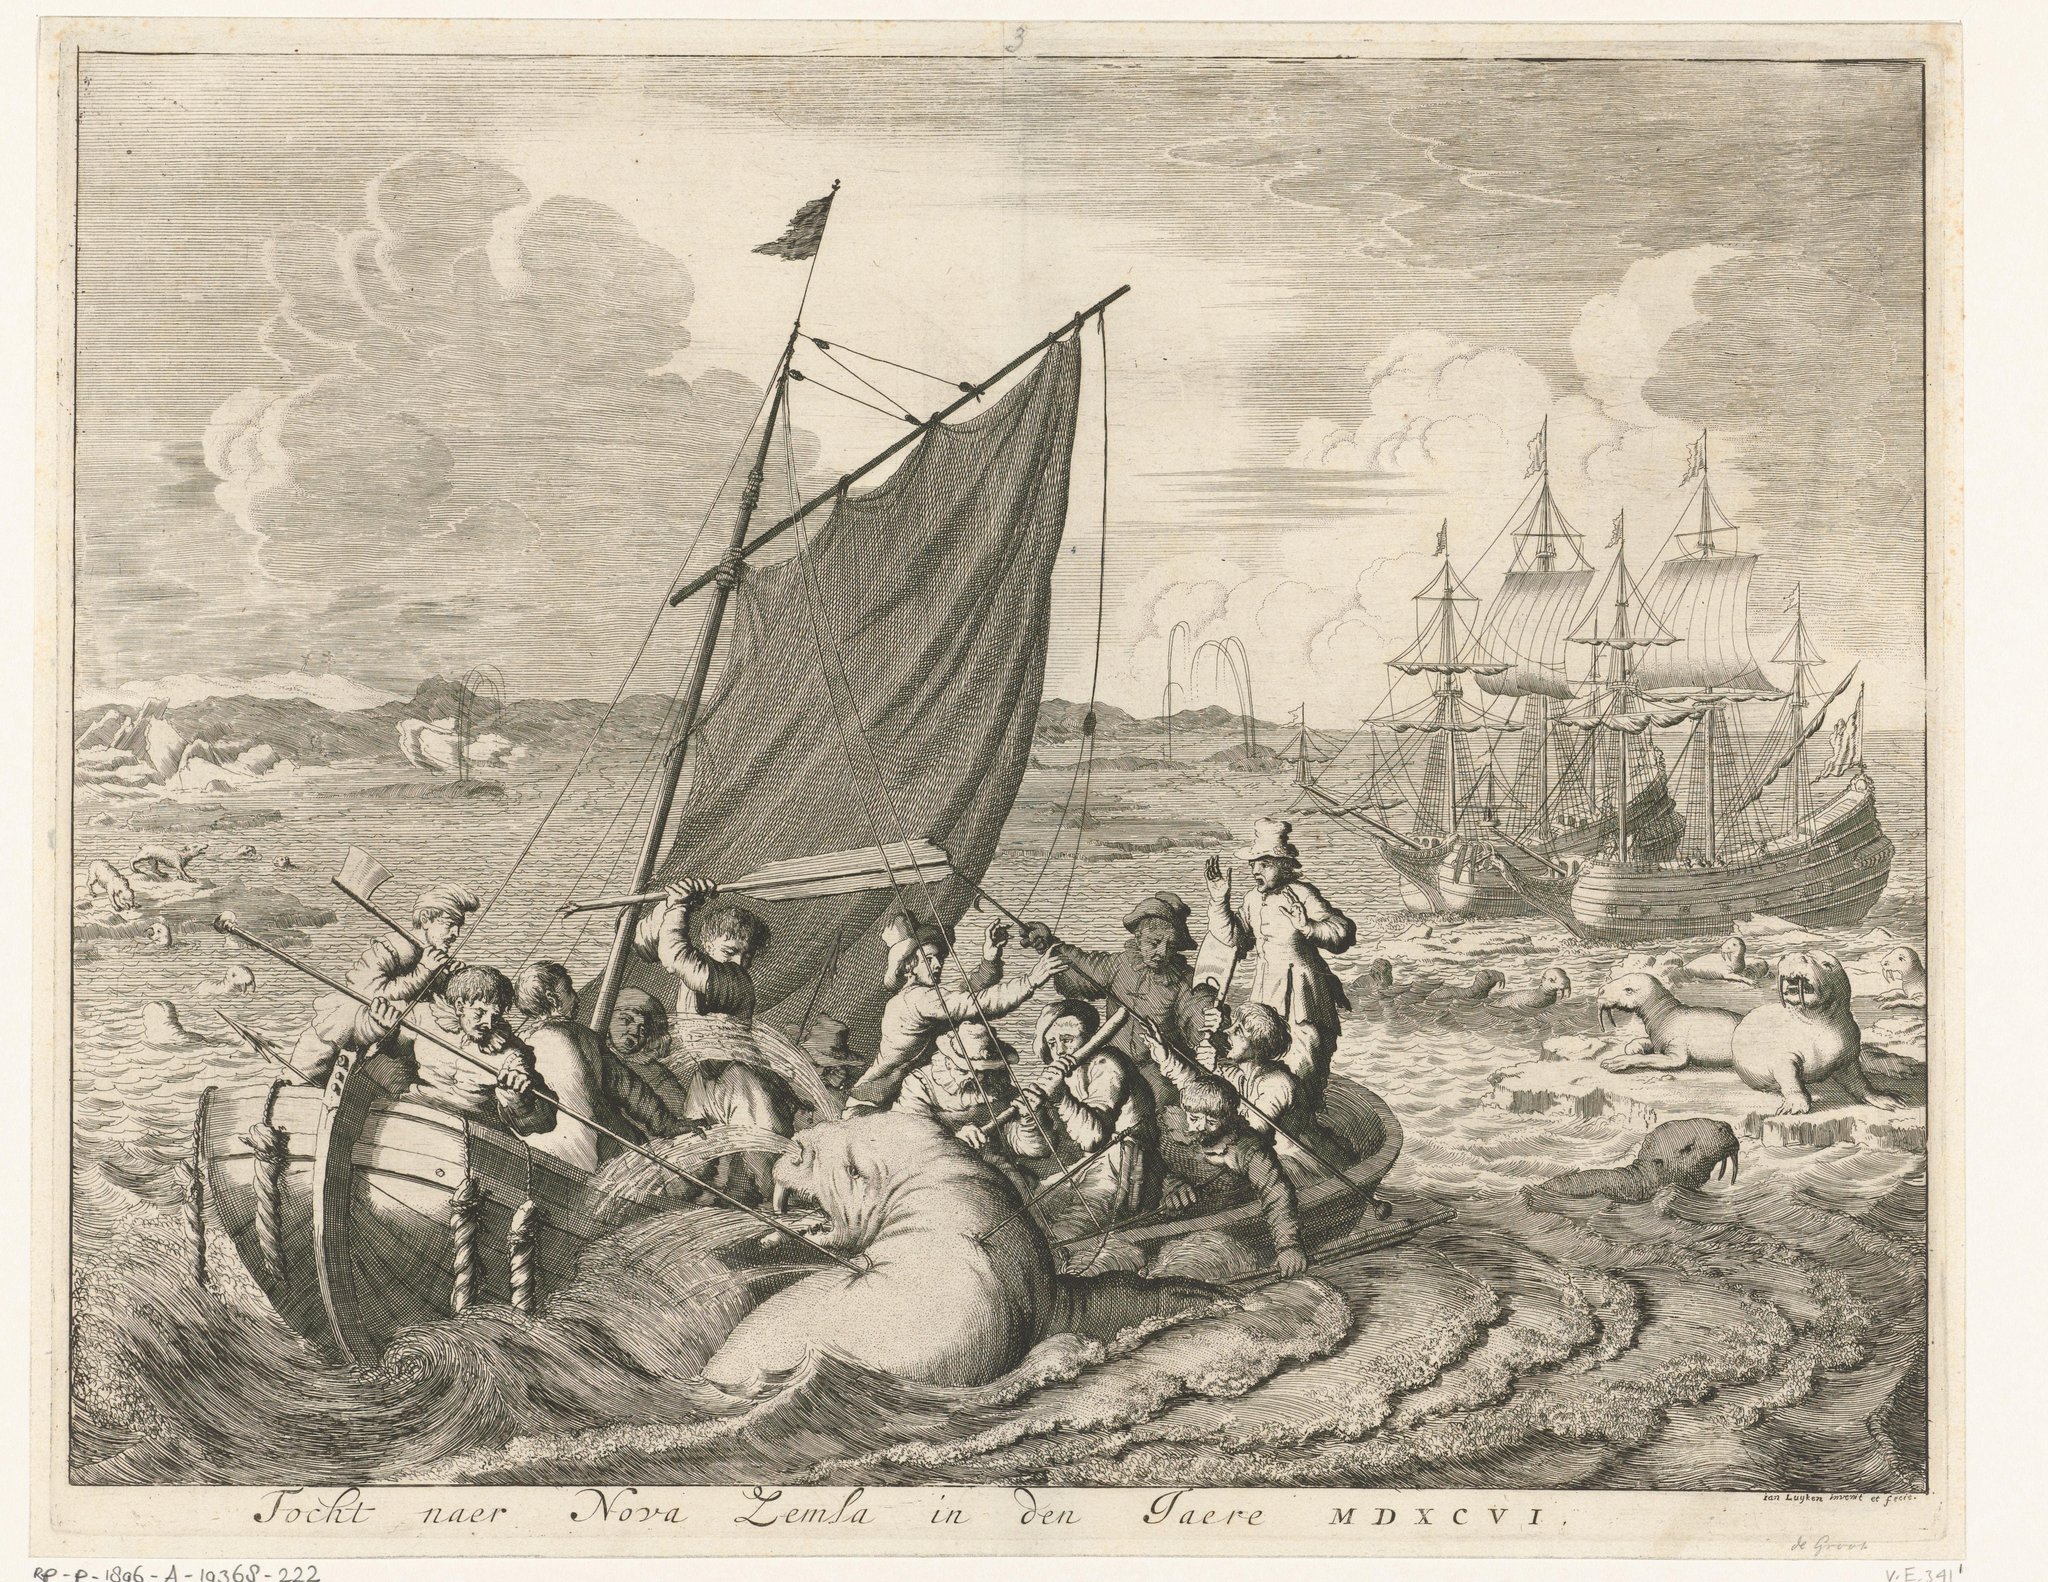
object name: print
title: Tocht naar Nova Zembla in 1596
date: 1681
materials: paper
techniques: etching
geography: amsterdam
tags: willem barendsz., jacob van heemskerck, exploration, expedition, voyage of discovery, swimming mammals: walrus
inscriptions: collector's mark: Lugt 2228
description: Gebruikt als illustratie in: Bor Christiaansz, Pieter. Oorsprongk, begin, en vervolgh der Nederlandsche oorlogen, 4 delen, dl. III (1681), p. 870. Amsterdam: weduwe Joannes van Someren, Abraham Wolfgang, Hendrick en Dirk Boom, 1679-1684. Tevens in: Groot, Hugo de. Nederlandtsche Jaerboeken en Historien. Amsterdam: weduwe Joannes van Someren, Abraham Wolfgang, Hendrick en Dirk Boom, 1681, p. 290.